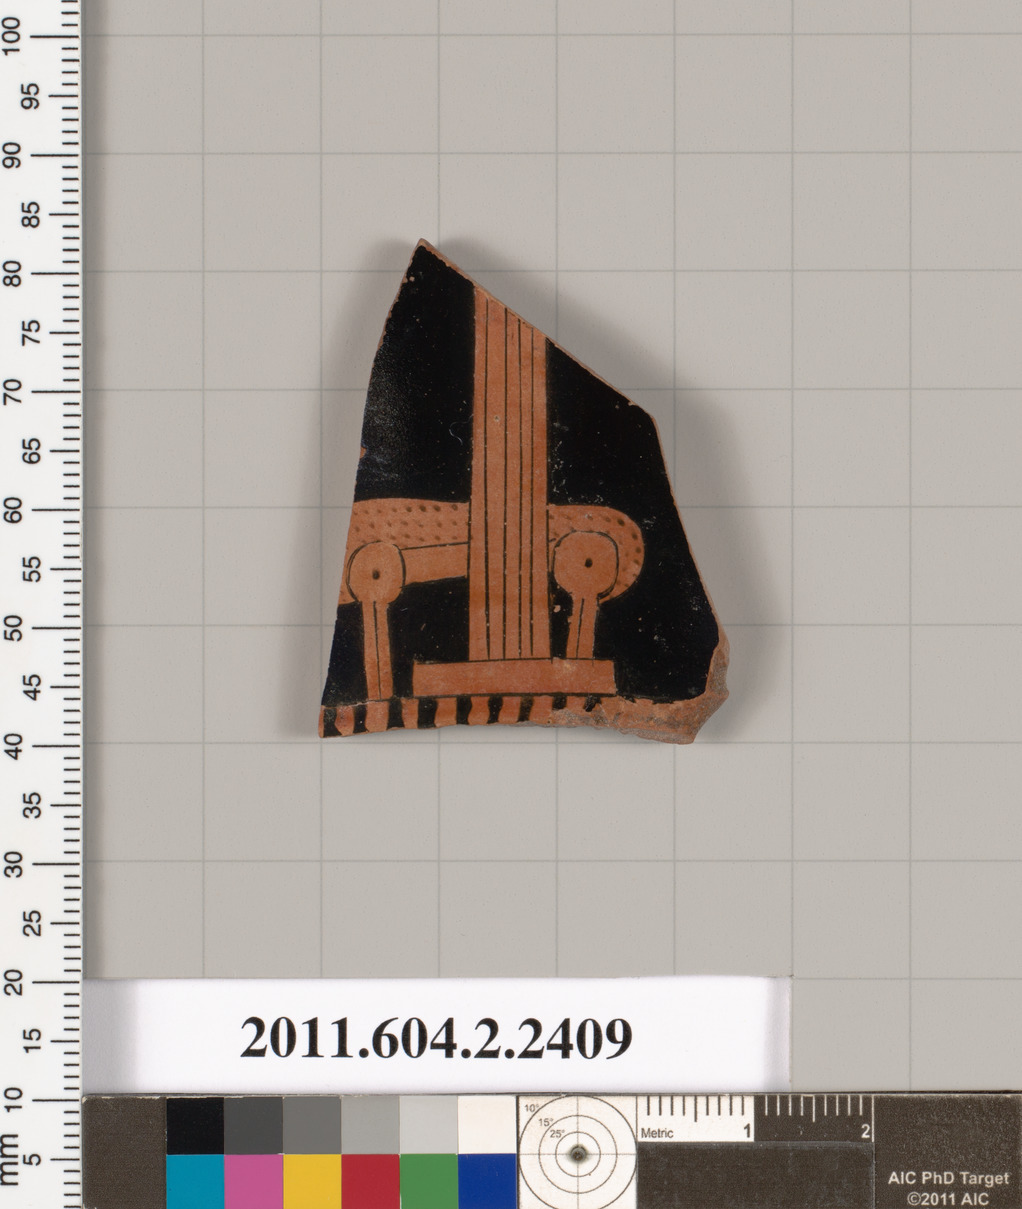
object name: rhyton fragment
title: Terracotta fragment of a rhyton (vase for libations or drinking)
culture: greek, attic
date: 470 BCE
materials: terracotta